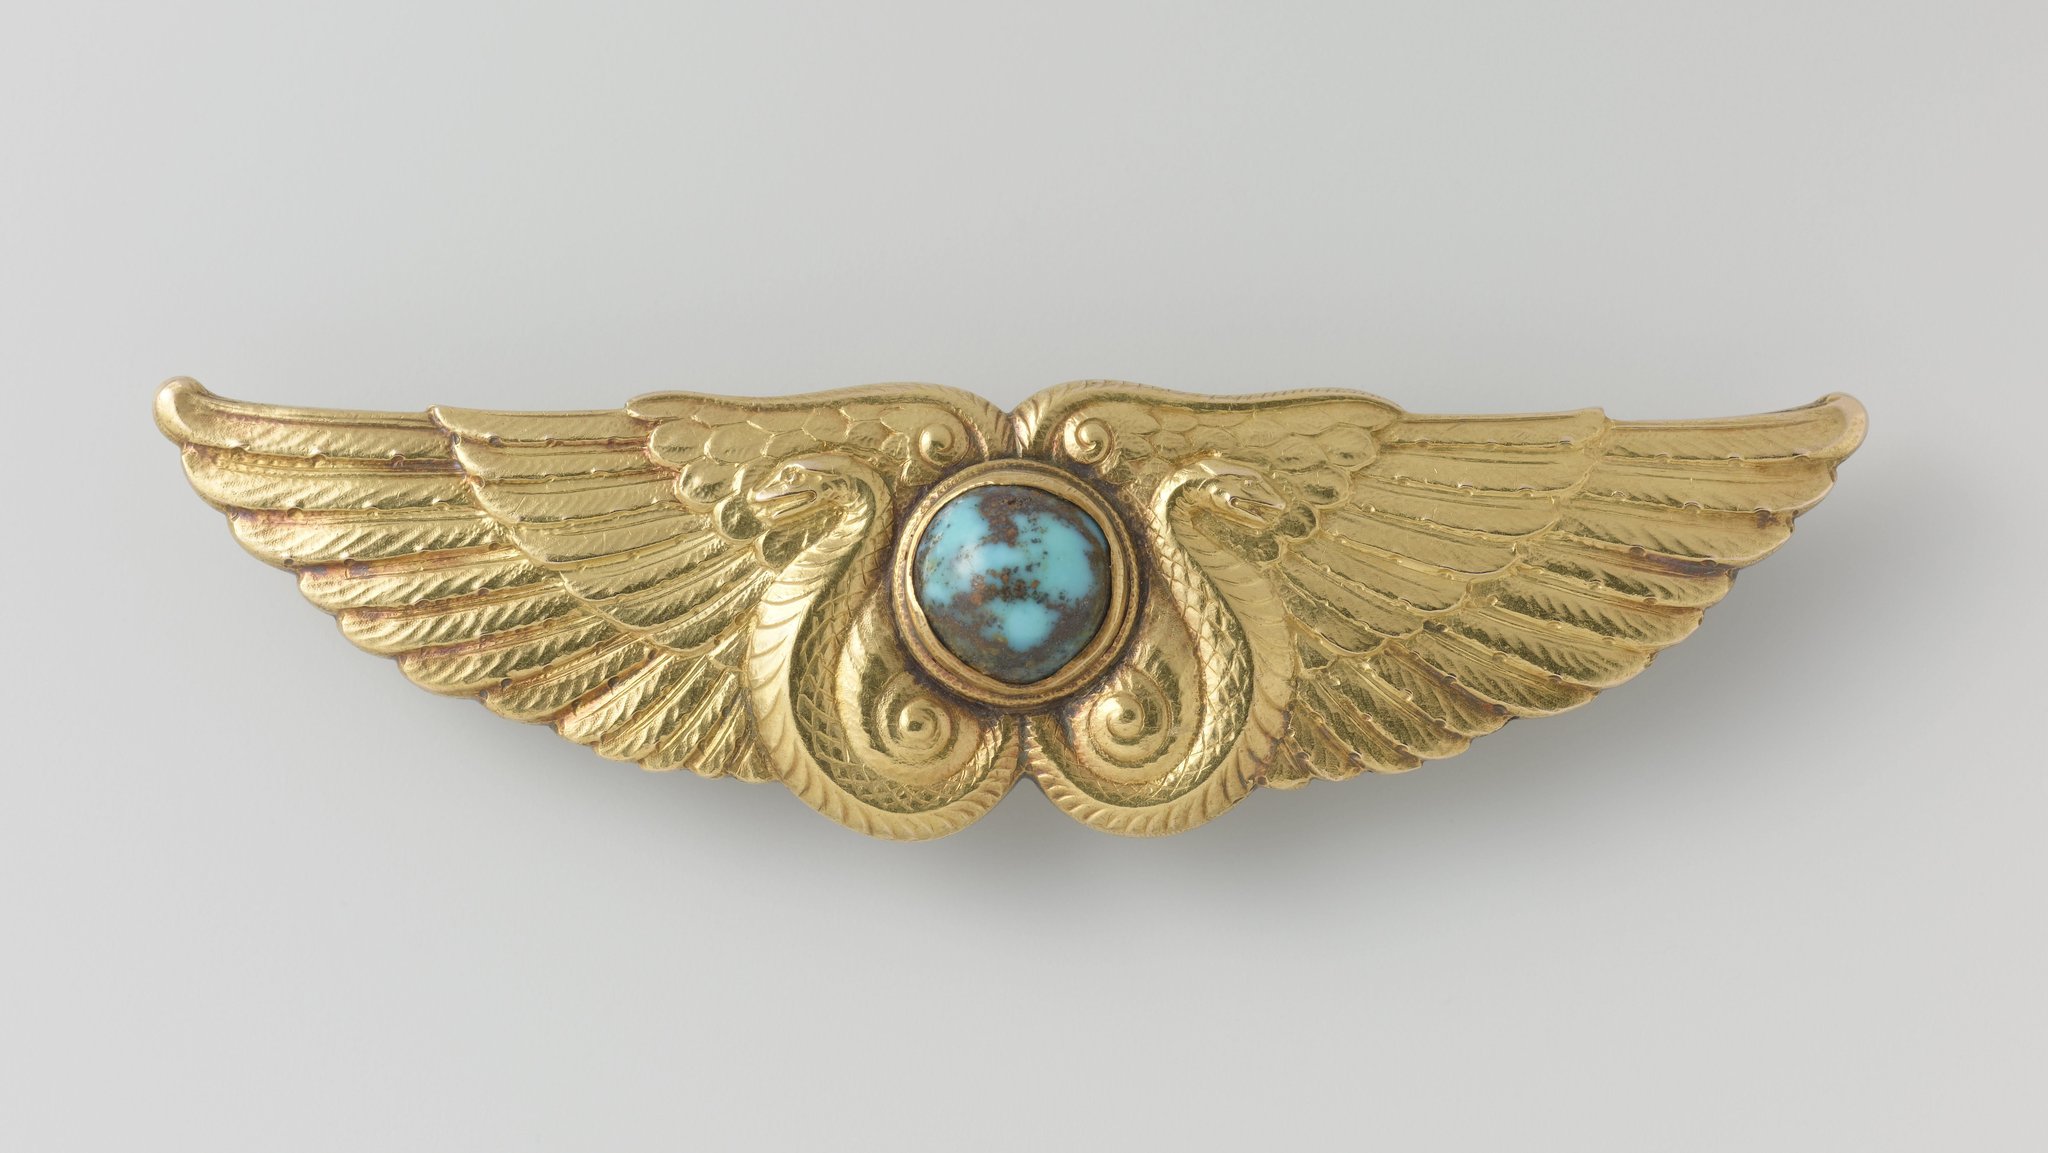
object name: jewellery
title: Broche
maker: frans zwollo (i)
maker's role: silversmith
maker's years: 1872-1945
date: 1906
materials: gold, gemstone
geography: amsterdam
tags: ornament ~ hybrid animals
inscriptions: maker's mark: ‘FZ in vierpas’, alloy mark: ‘leeuwenkop naar links (Nederland, vanaf 1906)’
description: Brooch. Gold and turquoise. Amsterdam, c. 1906, by Frans Zwollo Sr.